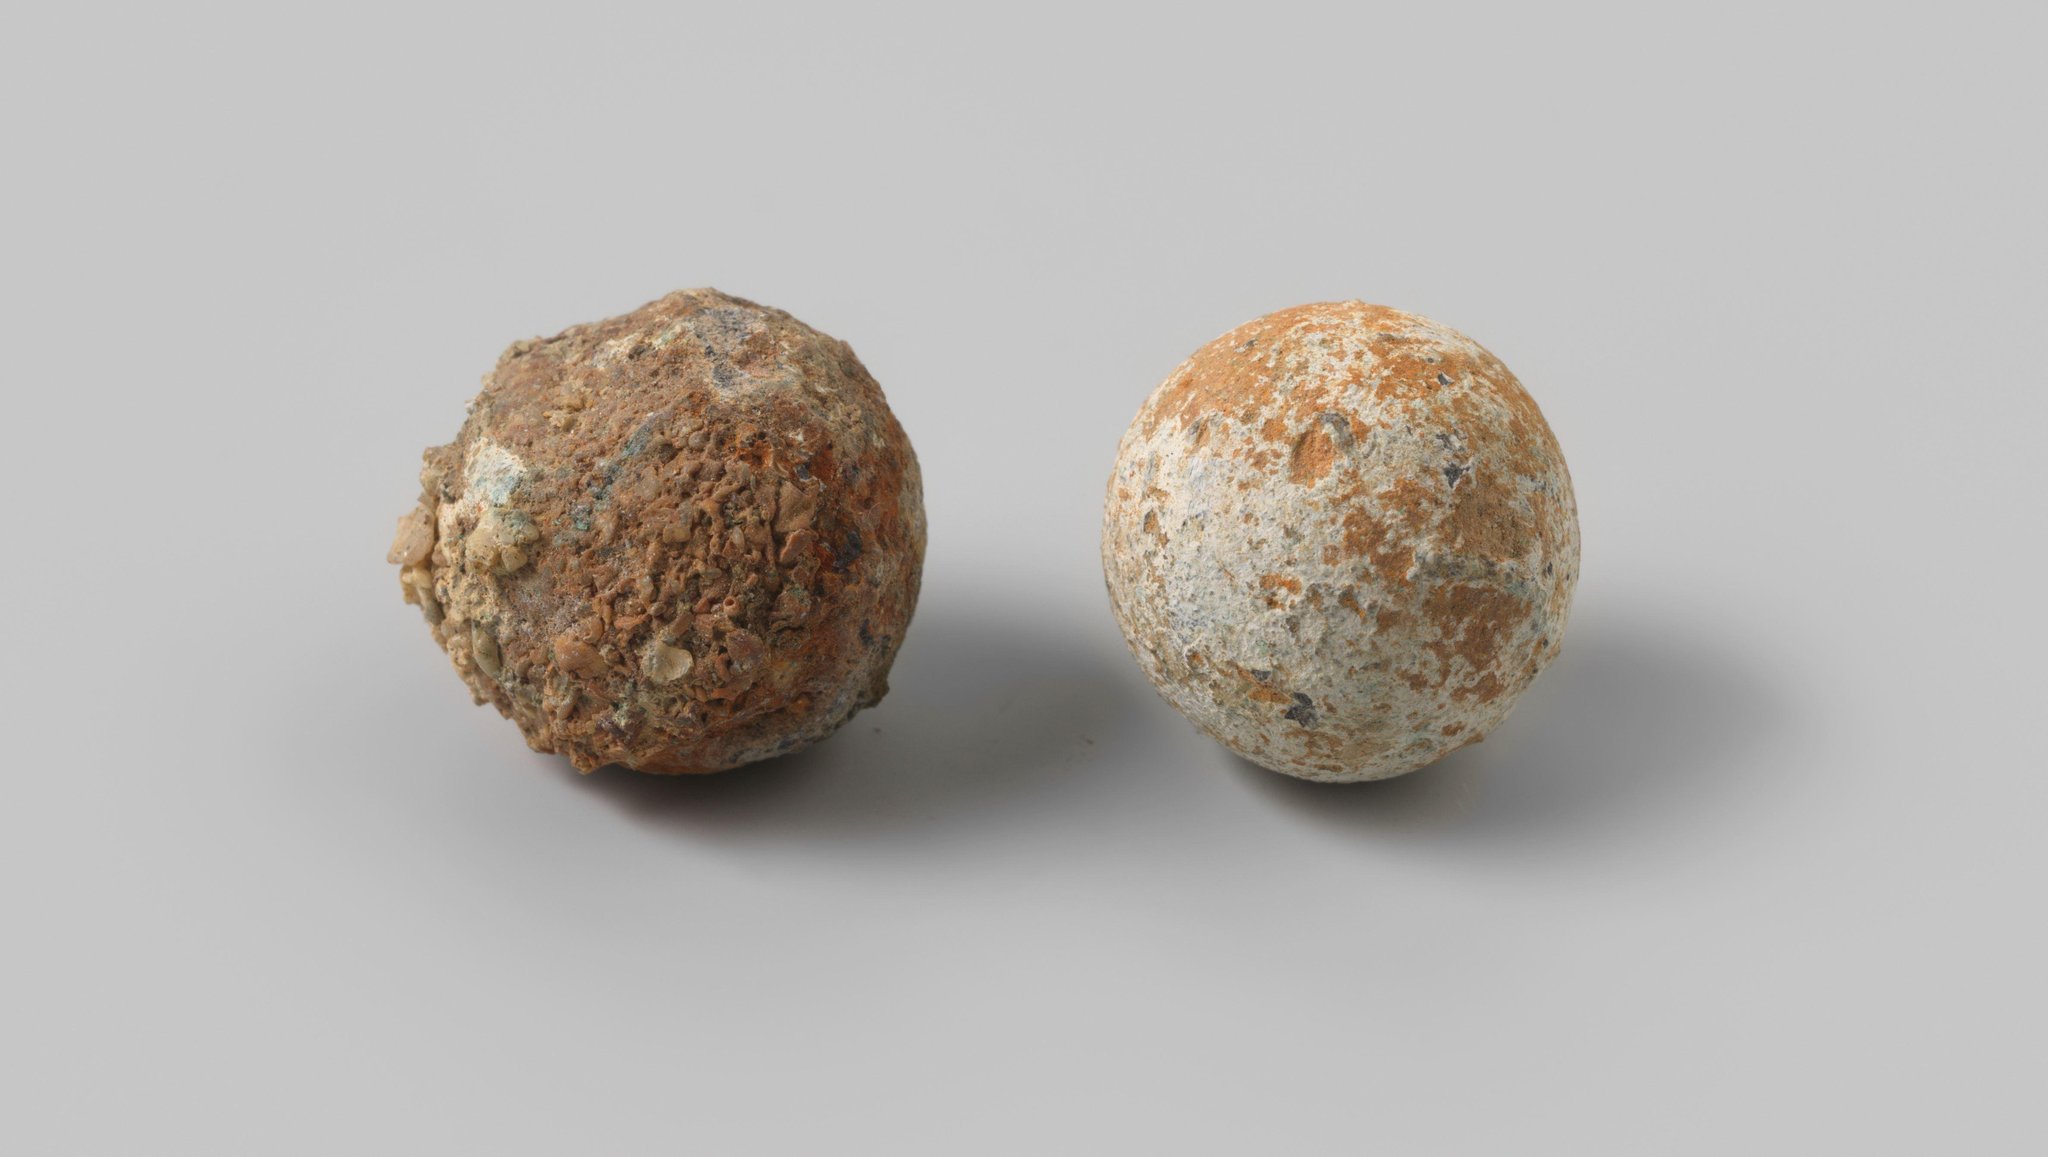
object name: musketkogel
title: Musketkogel uit het wrak van de Oost-Indiëvaarder Hollandia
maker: Anonymous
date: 1700-1743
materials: lead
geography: netherlands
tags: verenigde oostindische compagnie, hollandia (schip), annet